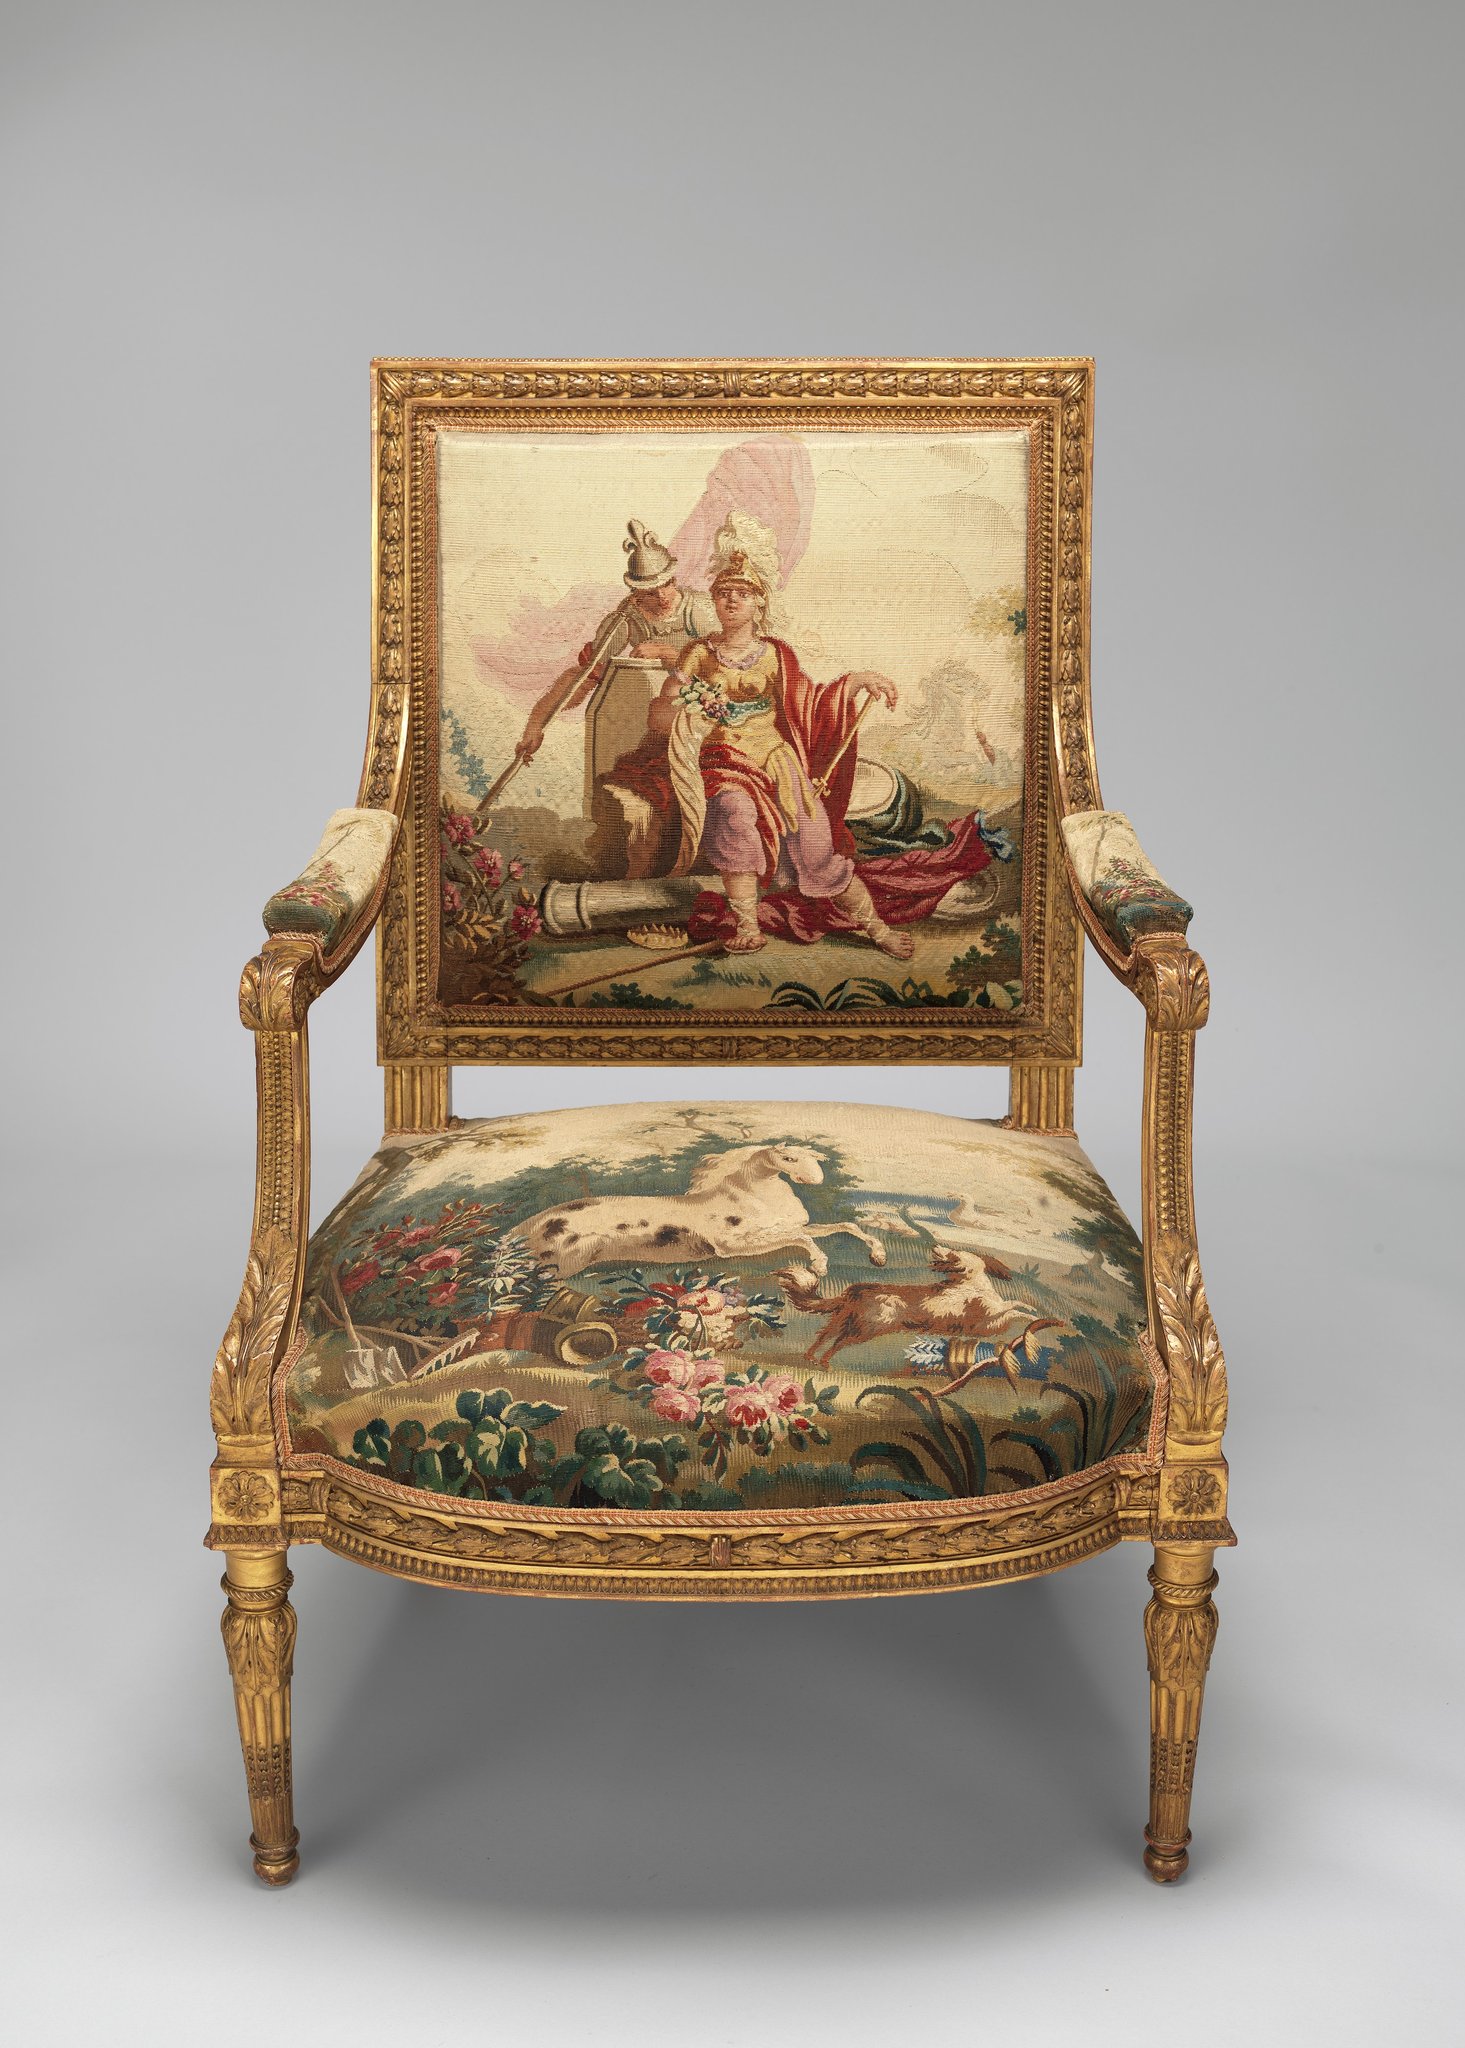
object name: armchair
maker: beauvais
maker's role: manufactory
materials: silk, wood, wool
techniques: carving, gilding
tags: men,women,dogs,horses